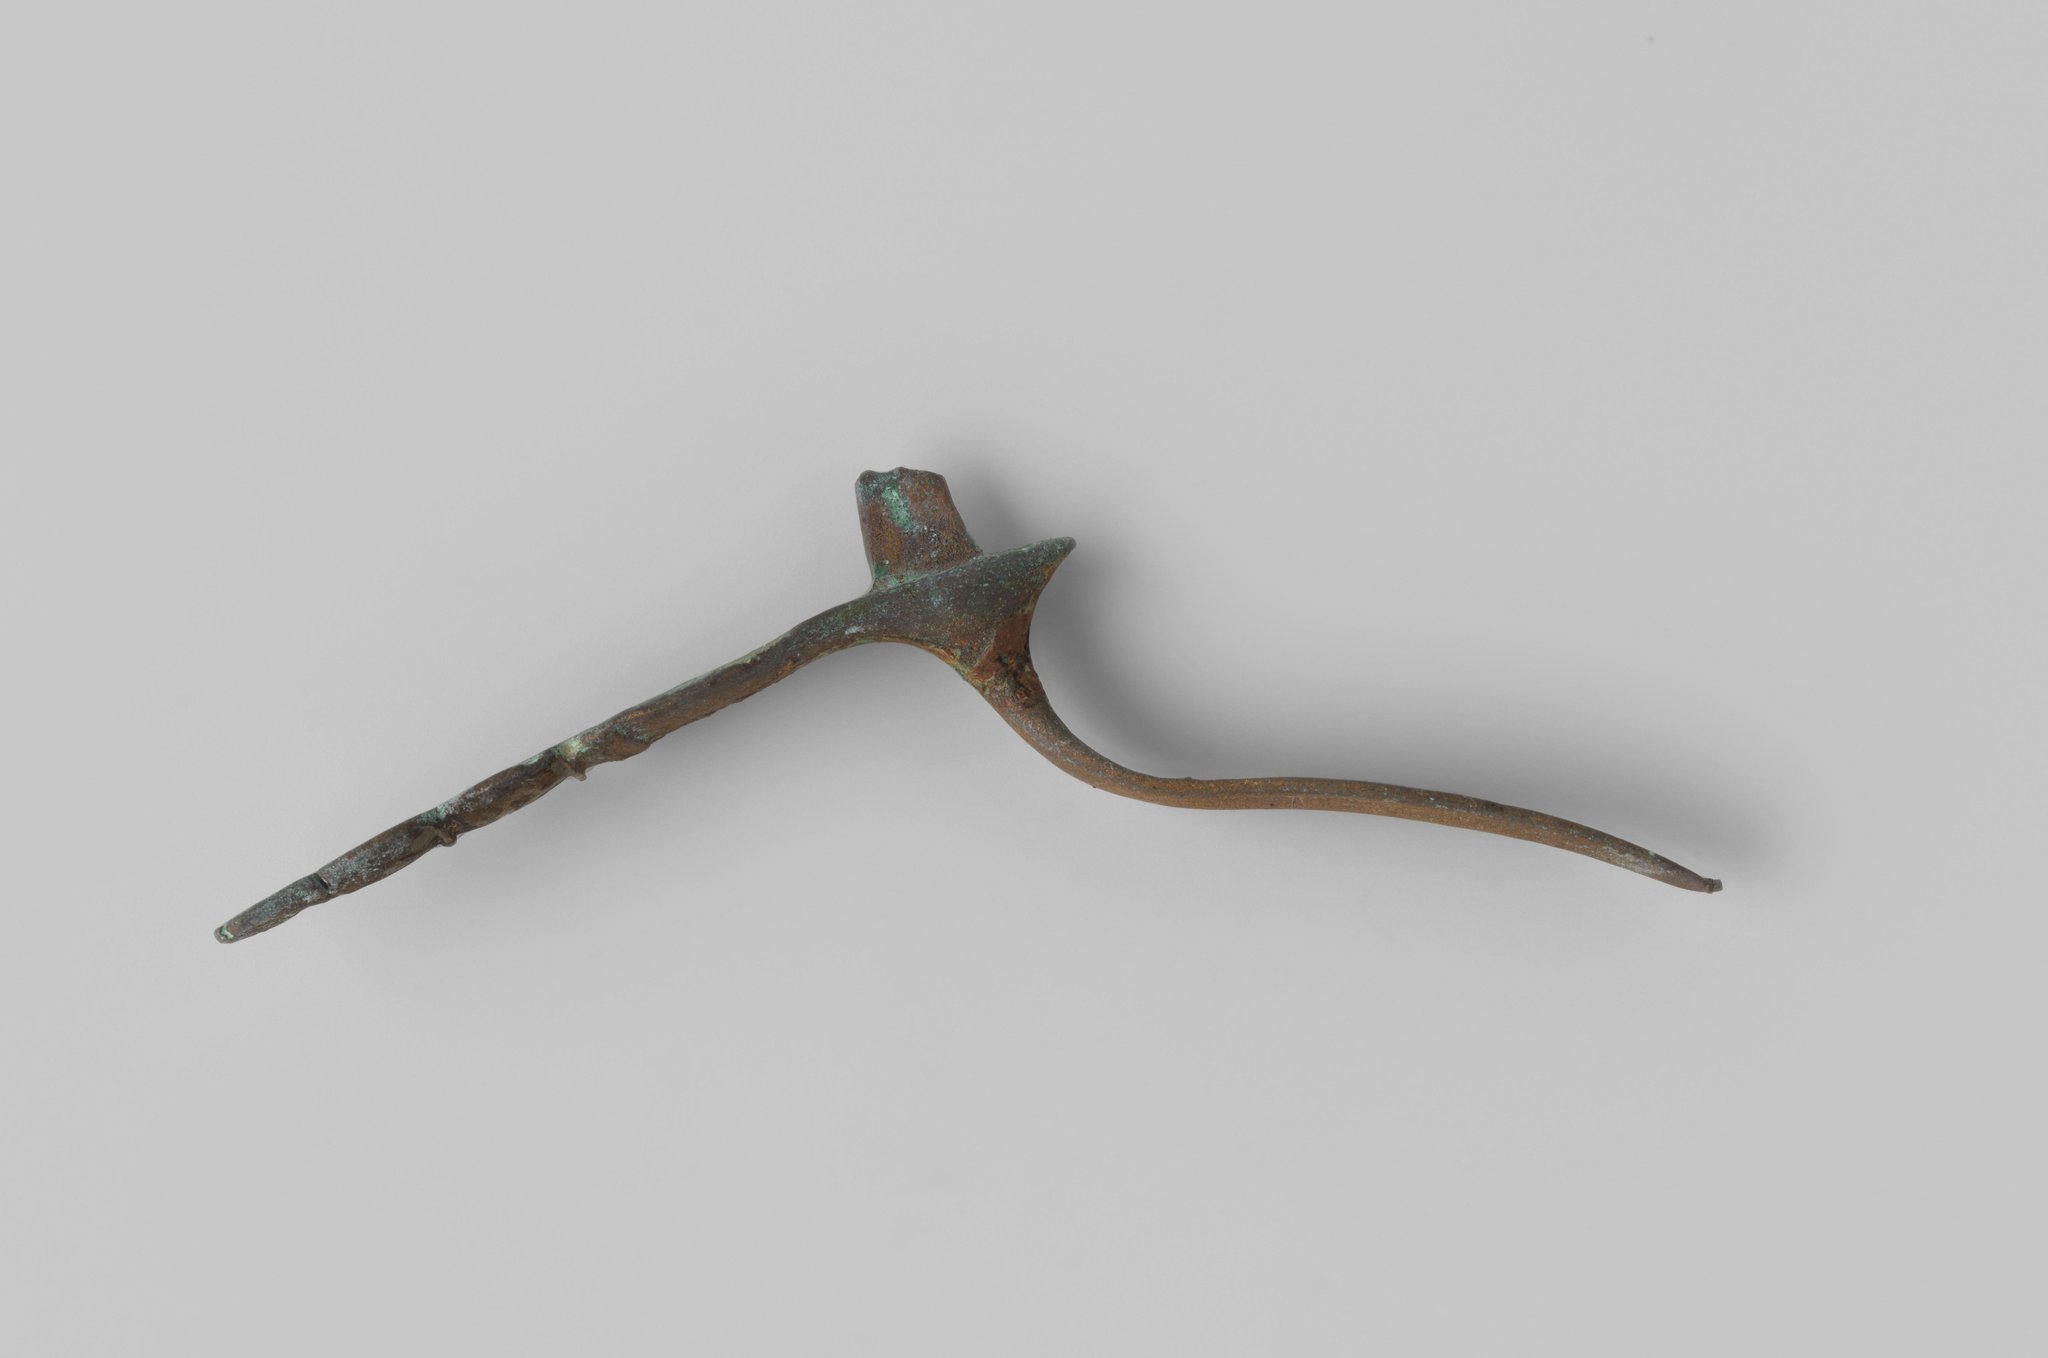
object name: trigger guard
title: Trekkerbeugel van een musket uit het wrak van de Oost-Indiëvaarder Hollandia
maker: Anonymous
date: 1700-1743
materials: copper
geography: netherlands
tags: verenigde oostindische compagnie, hollandia (schip), annet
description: Musket, trigger guard; fragm, front end (finial) and pontet fragm, id. NG 1980-27H2613.